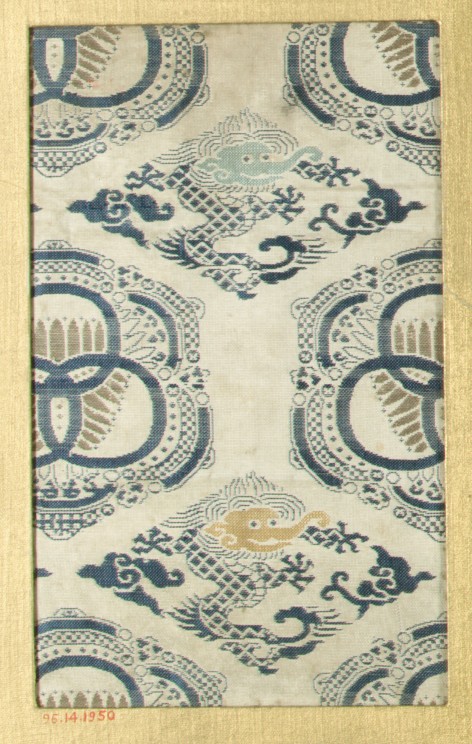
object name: piece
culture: japanese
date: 1701-1900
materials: silk